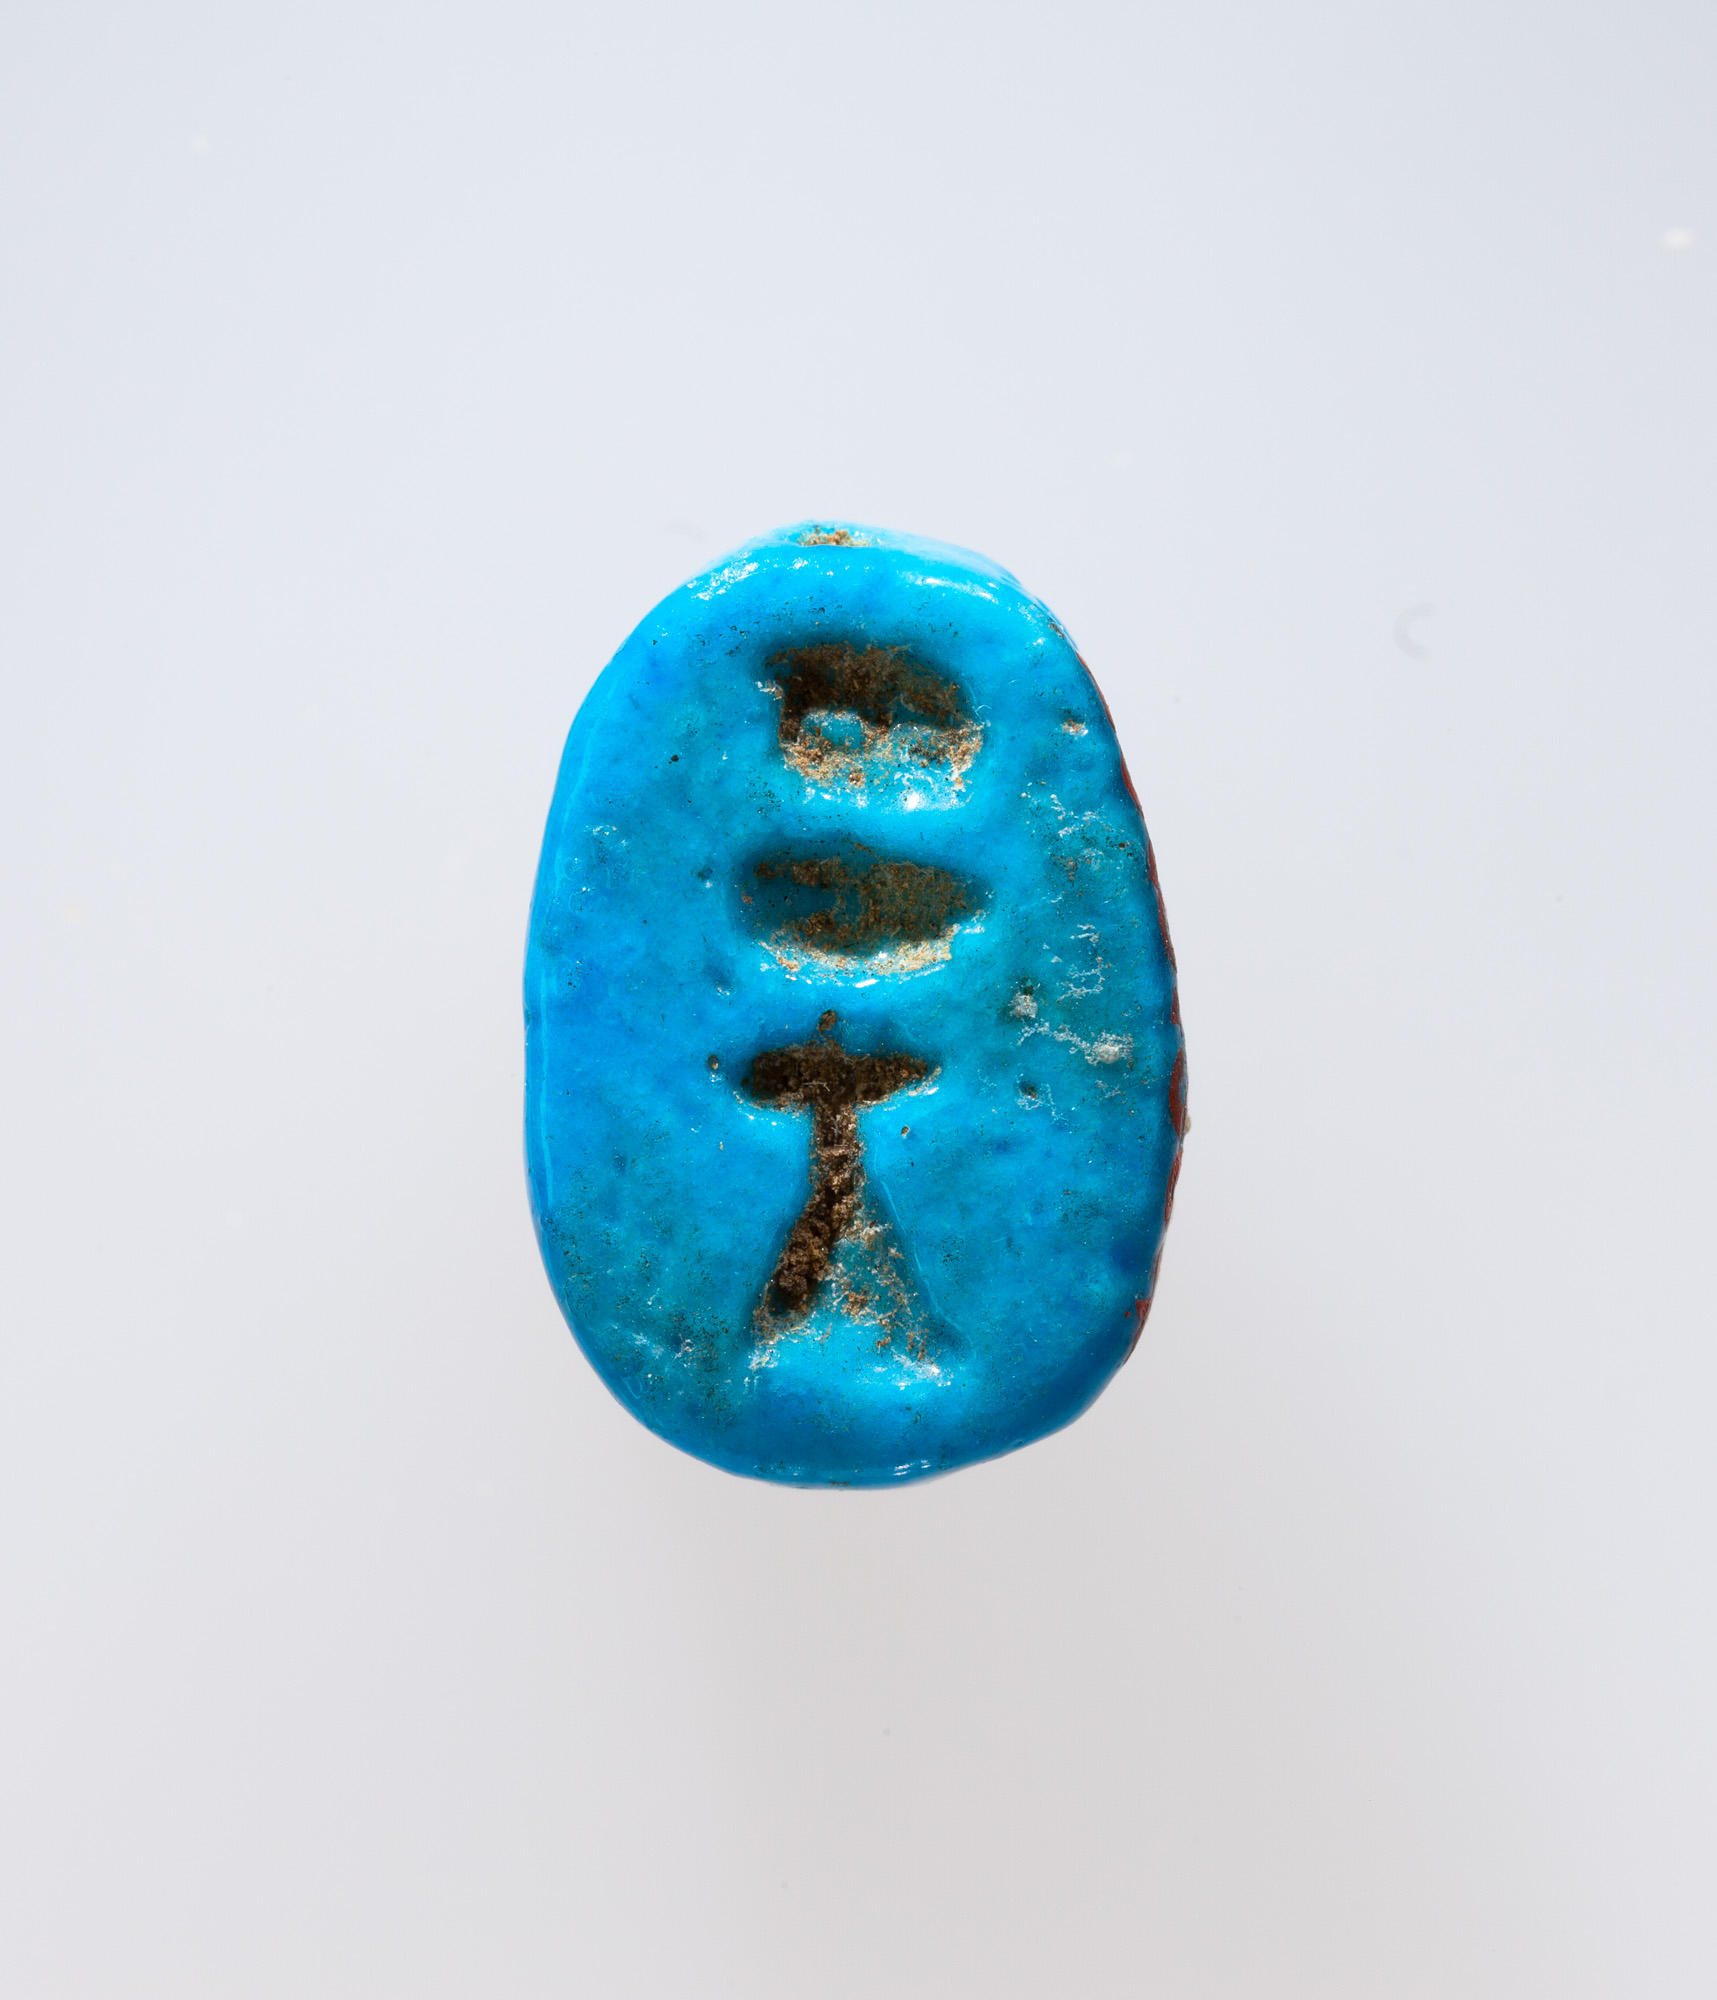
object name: scarab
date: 1479-1458 BCE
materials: faience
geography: egypt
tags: scarabs